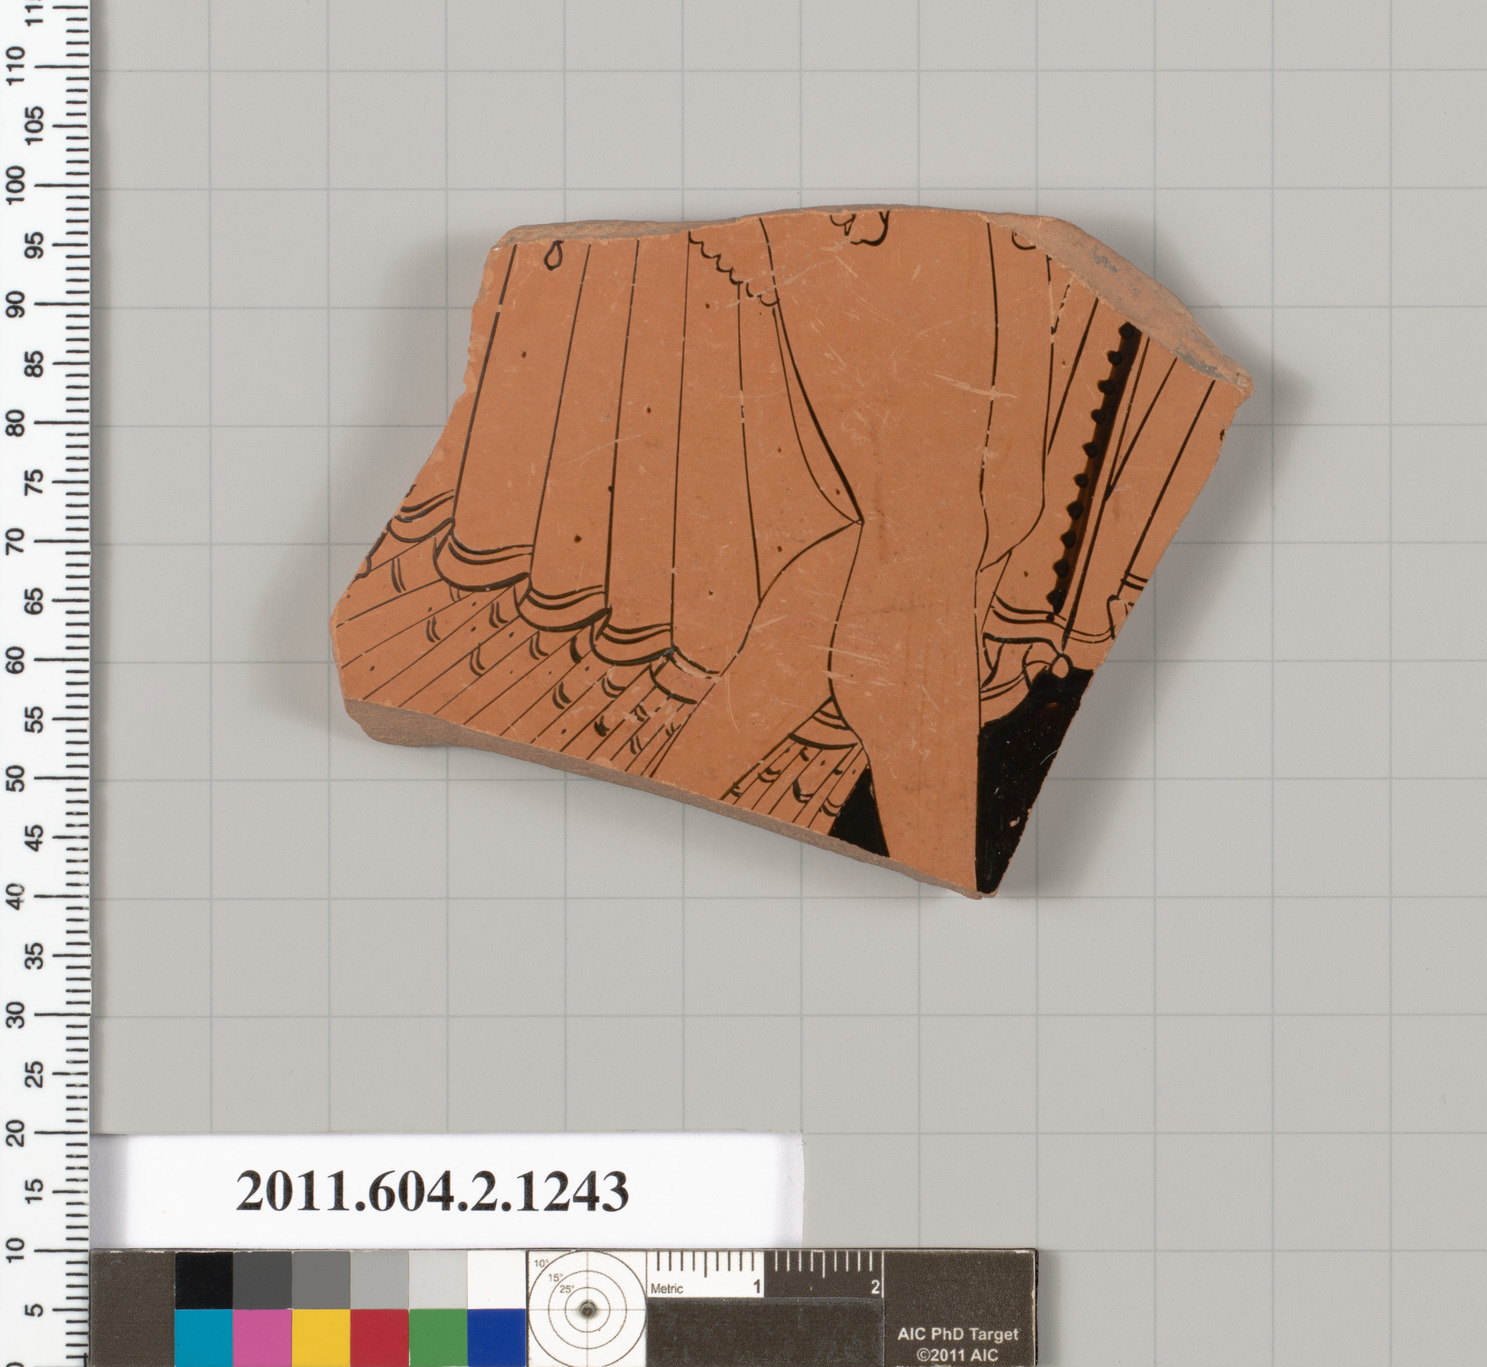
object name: skyphos fragment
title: Terracotta fragment of a skyphos (deep drinking cup)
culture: greek, attic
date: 500-480 BCE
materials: terracotta